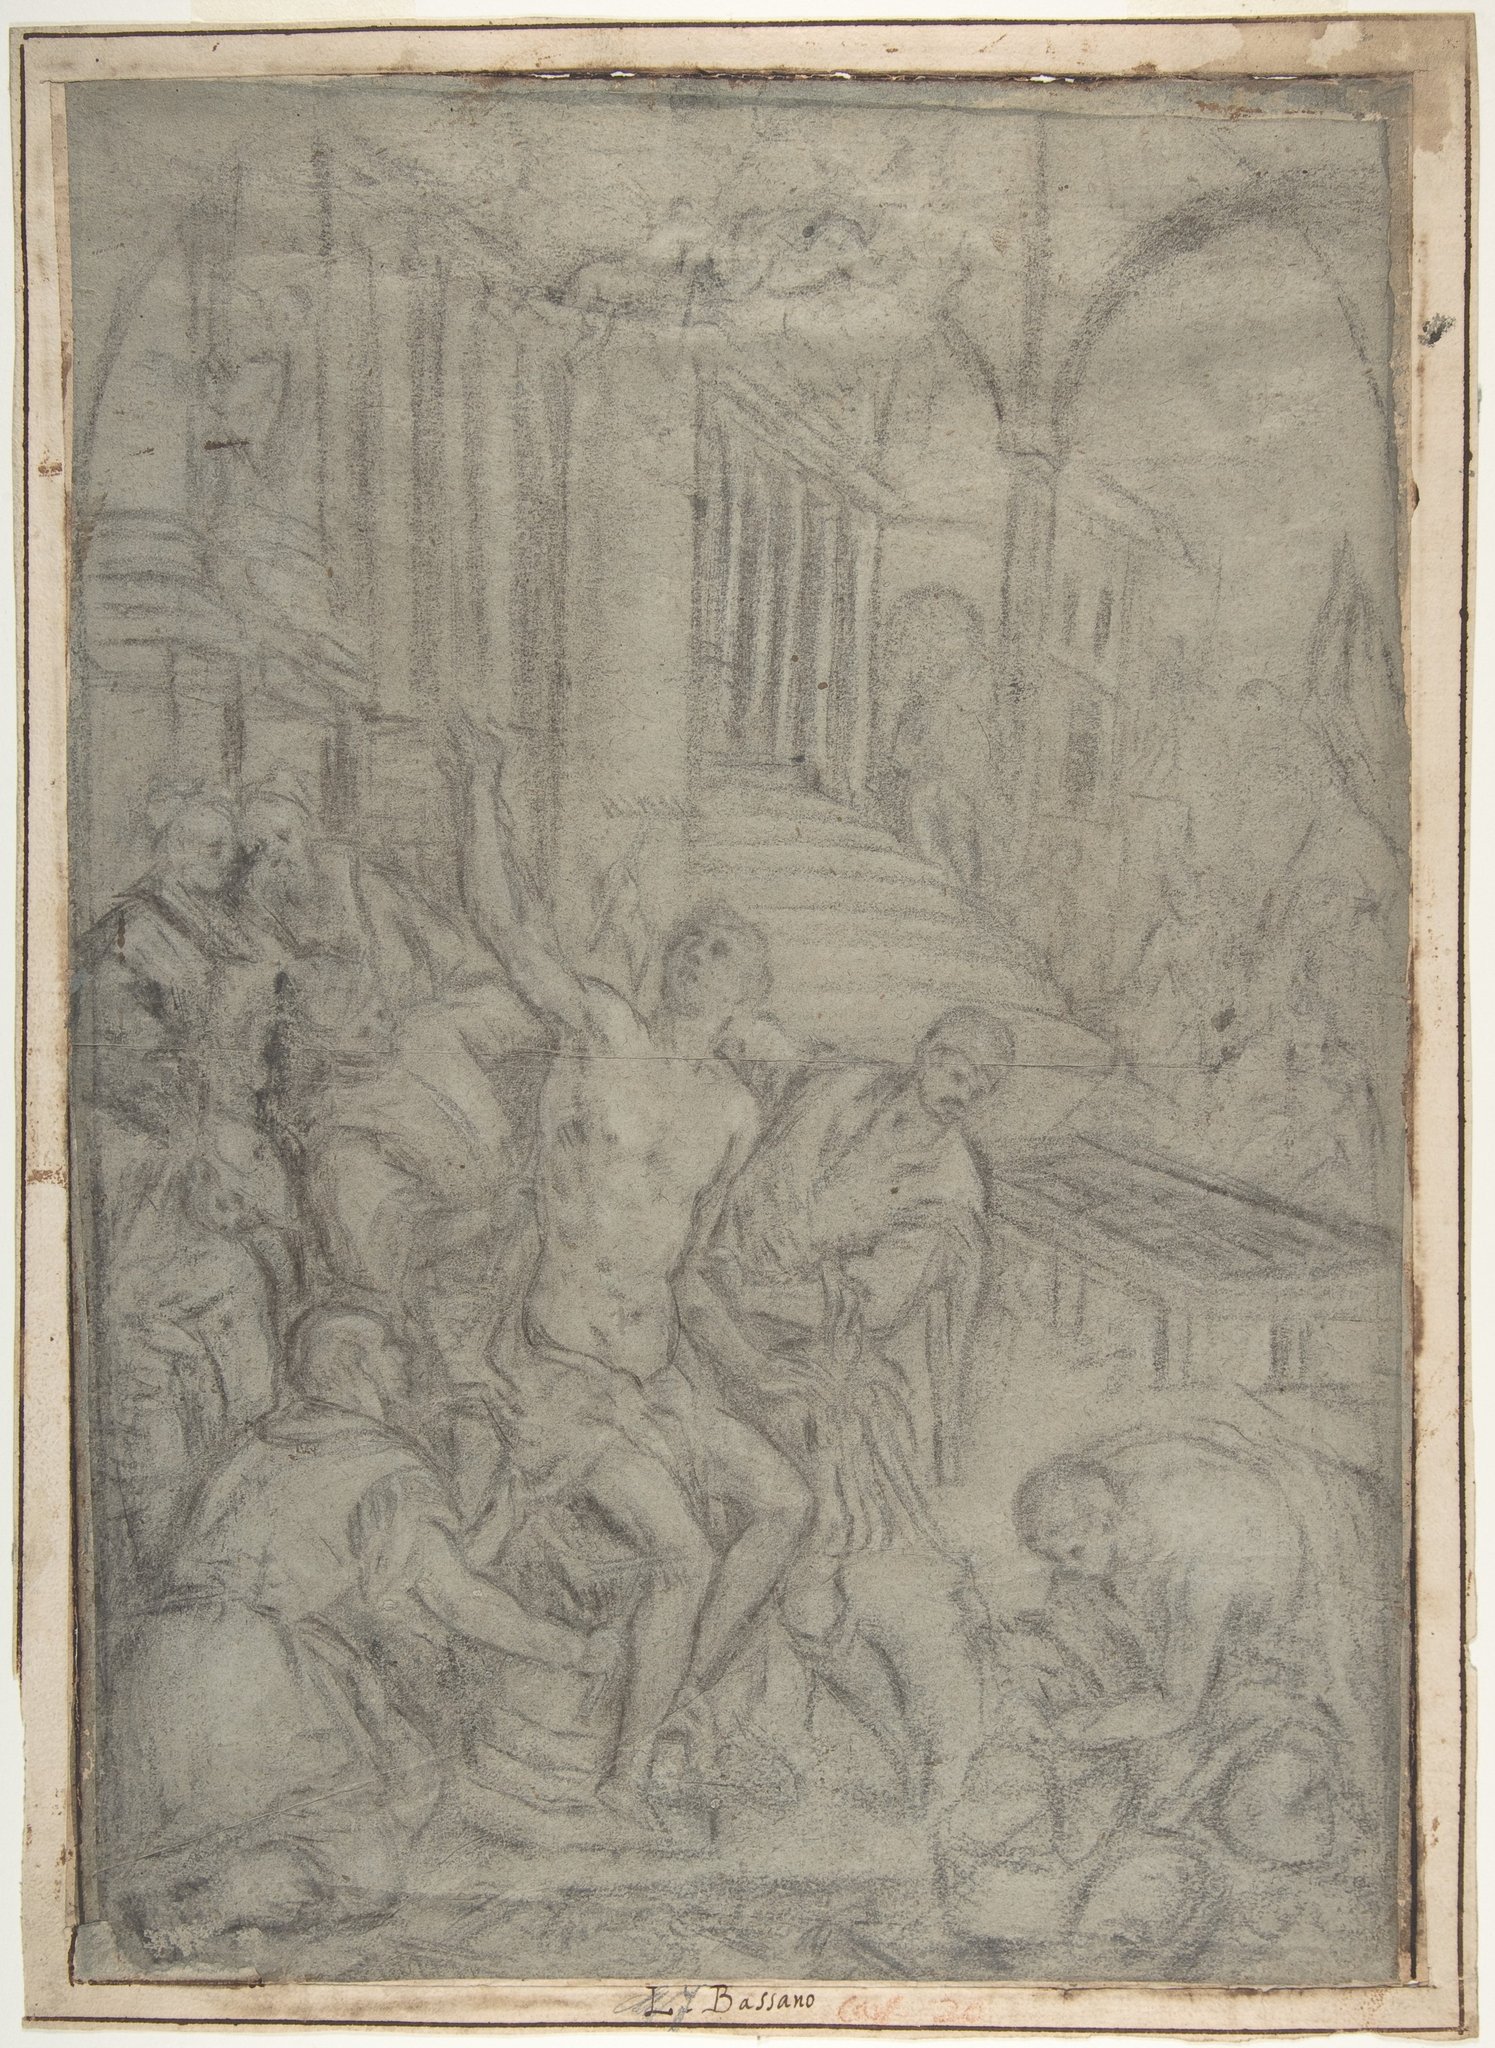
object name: drawing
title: The Martyrdom of Saint Lawrence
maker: leandro bassano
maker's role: artist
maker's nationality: italian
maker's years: 1557-1622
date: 1557-1622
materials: chalk, paper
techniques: highlighting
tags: suffering,men,saint lawrence